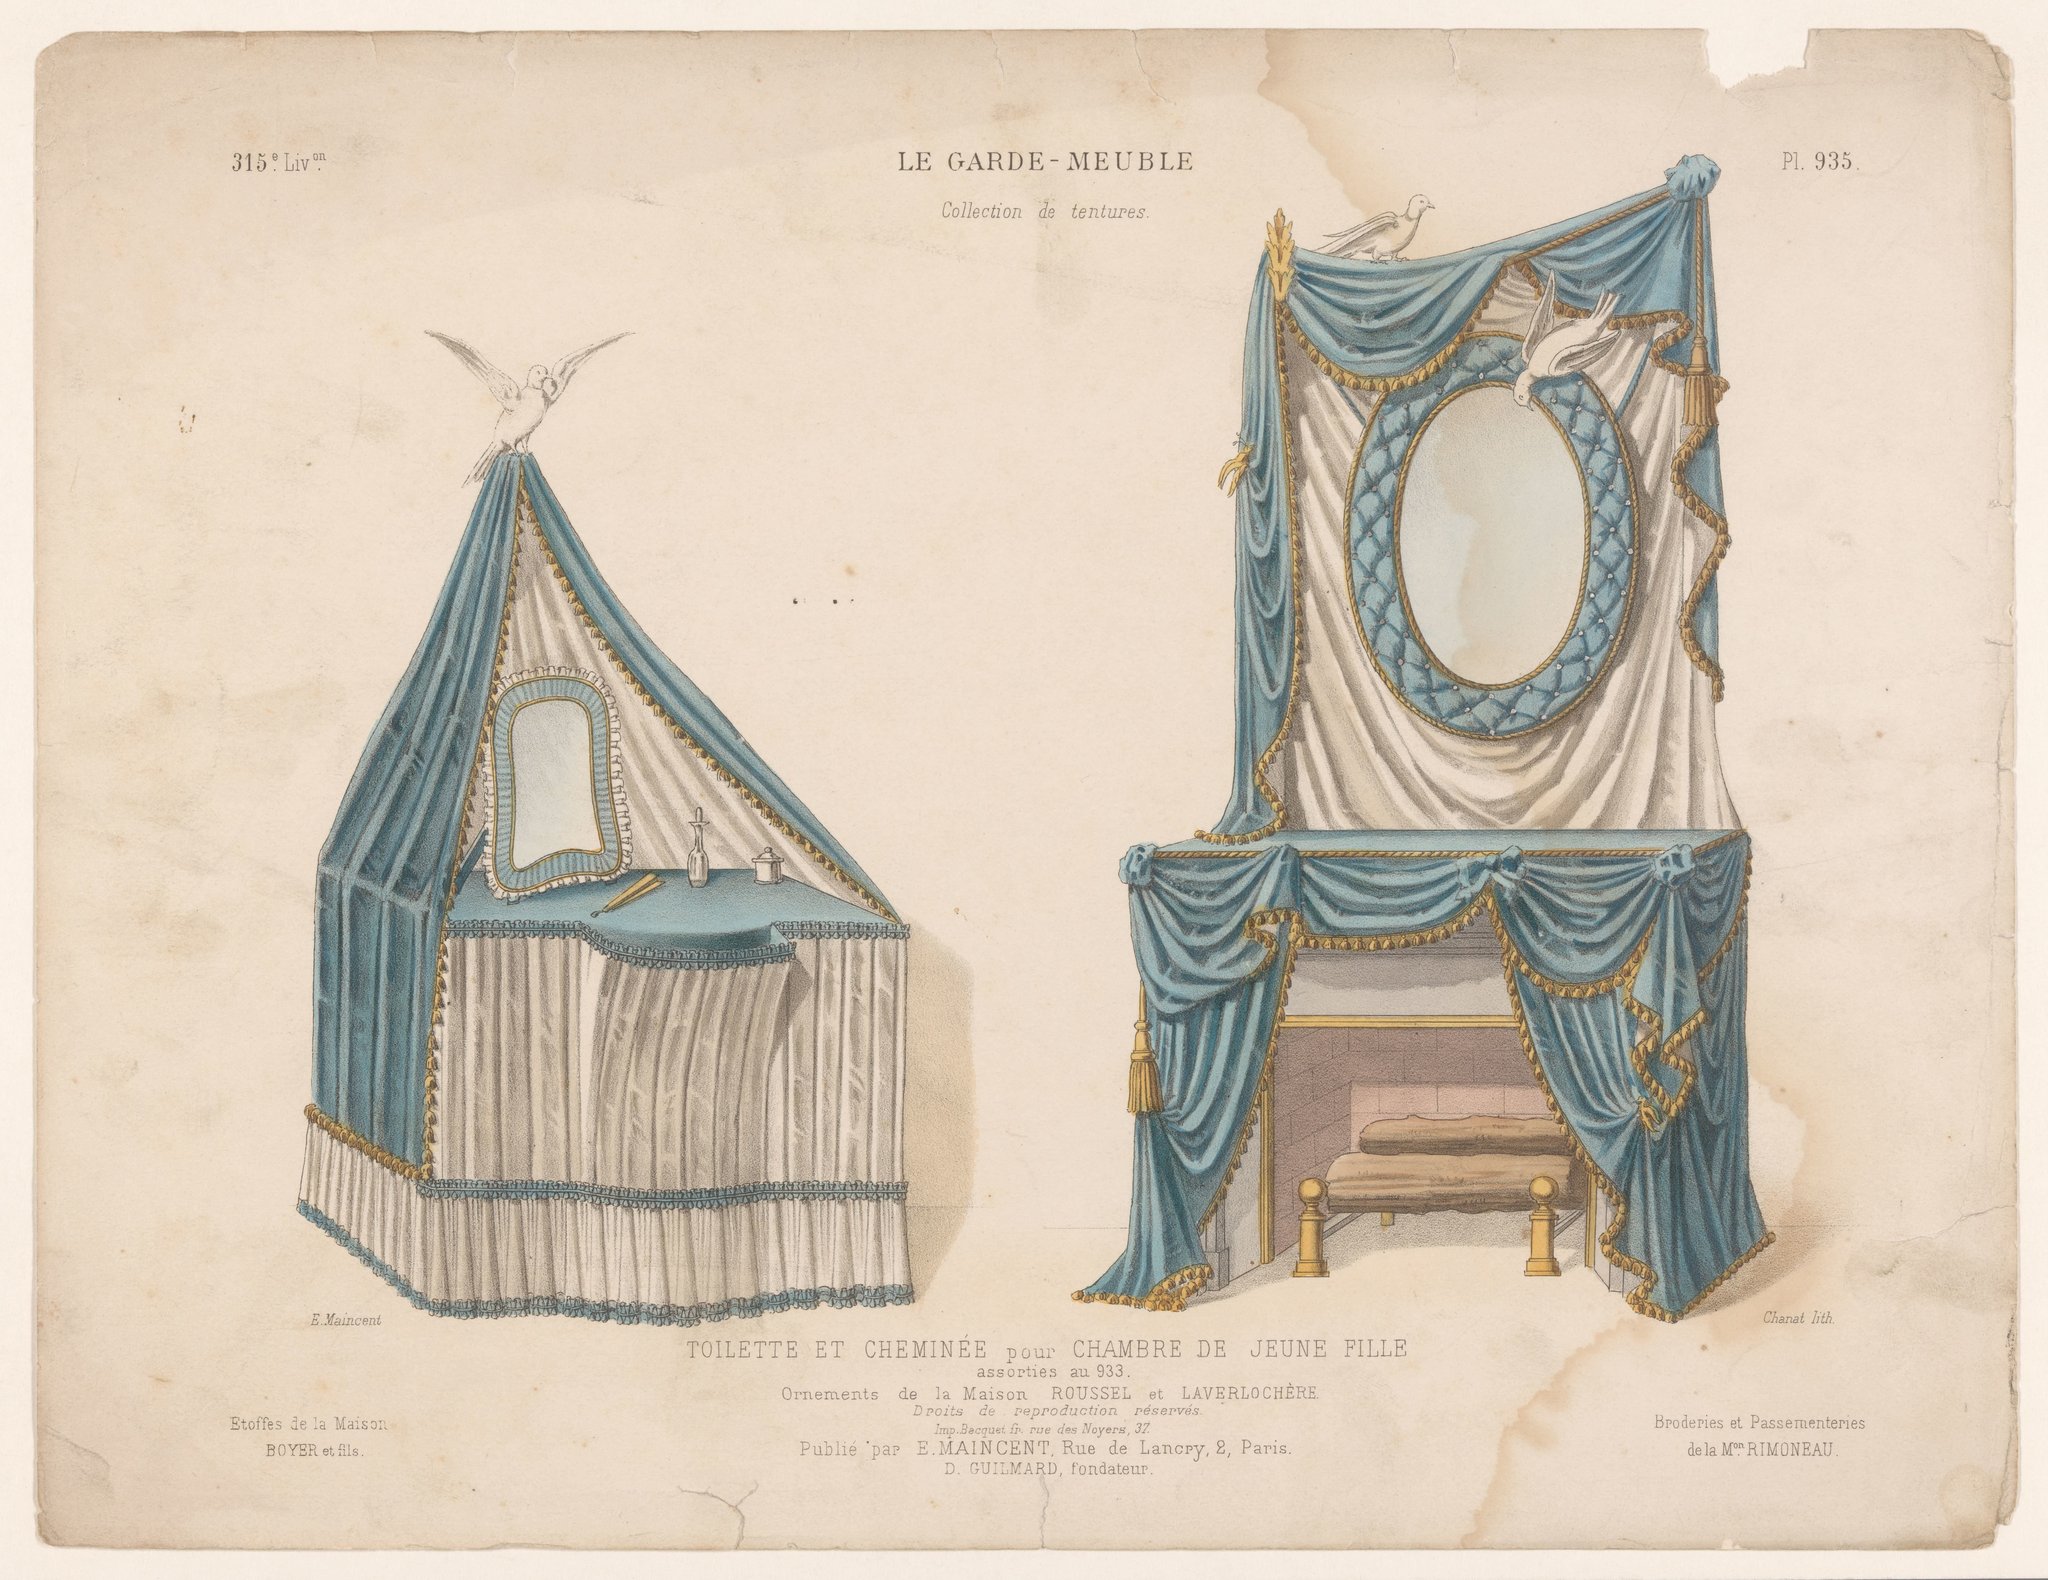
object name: print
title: Toilette et Cheminée pour Chambre de jeune Fille / assorties au 933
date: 1885-1895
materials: paper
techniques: hand coloring, lithograph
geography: paris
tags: decorations (interior of the house), open hearth, fire-place, hangings and drapery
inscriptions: : ‘Droits de reproduction réservés.’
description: Toilettafel en haard met draperieën voor een meisjeskamer. Prent uit 315e Livraison, behorend bij serienr. 933.